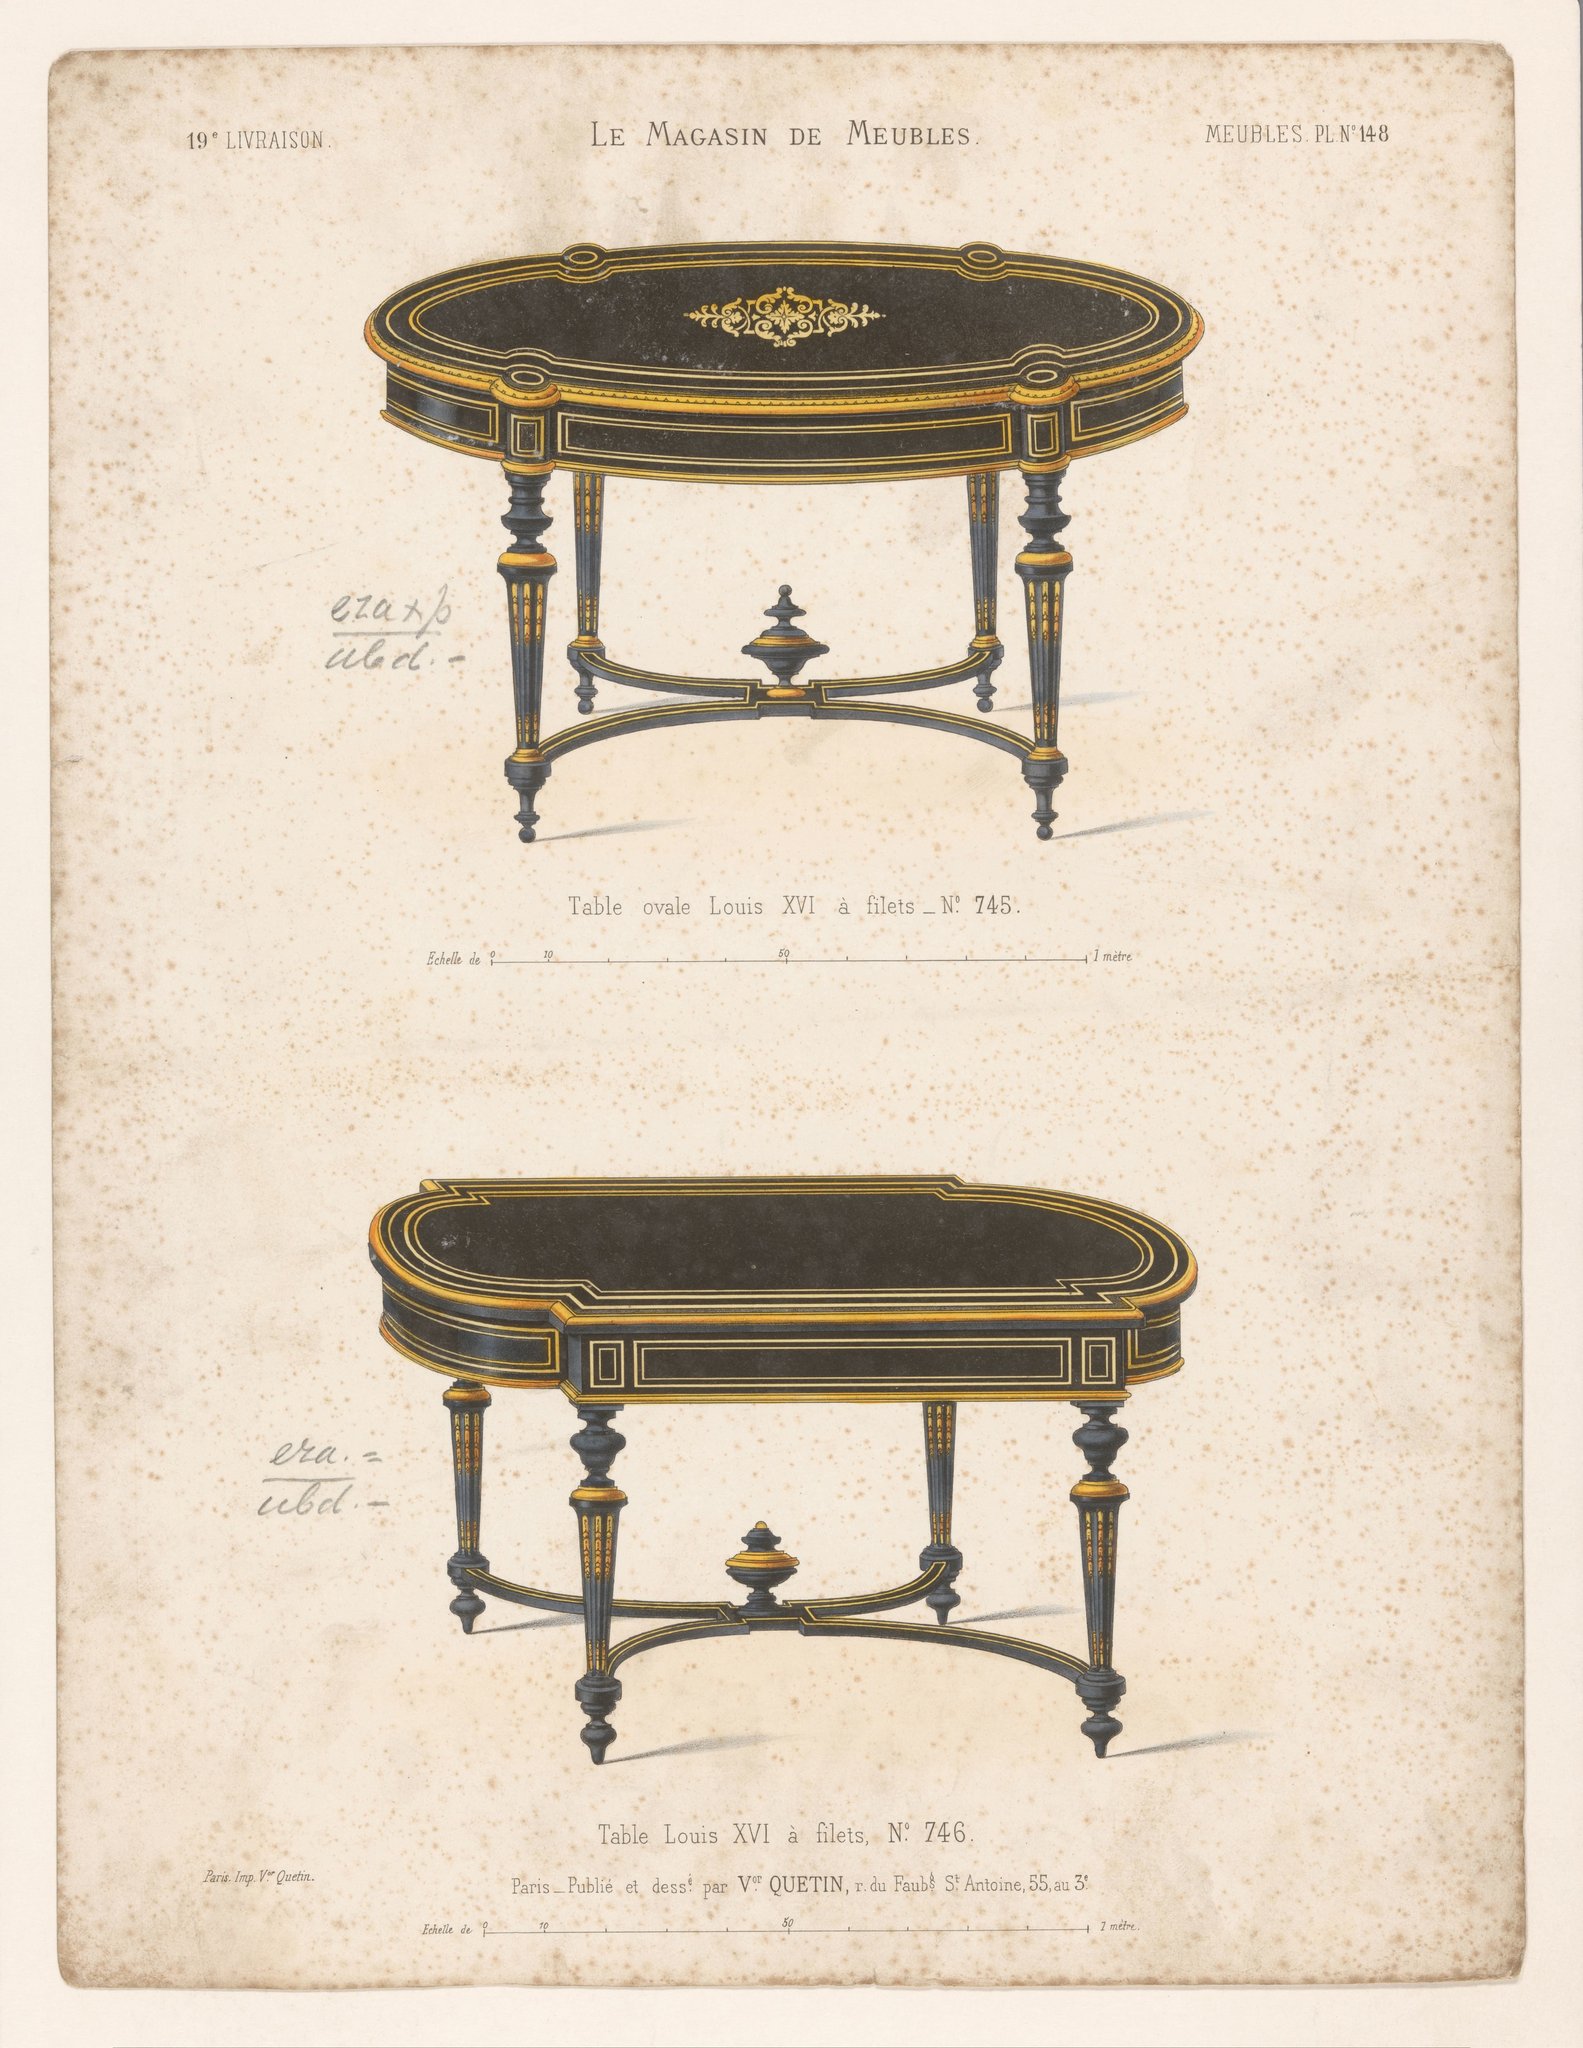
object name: print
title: Twee tafels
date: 1832-1877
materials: paper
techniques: hand coloring, lithograph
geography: paris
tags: table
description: Twee ovale tafels in de Lodewijk XVI-stijl. Prent uit 19e Livraison.